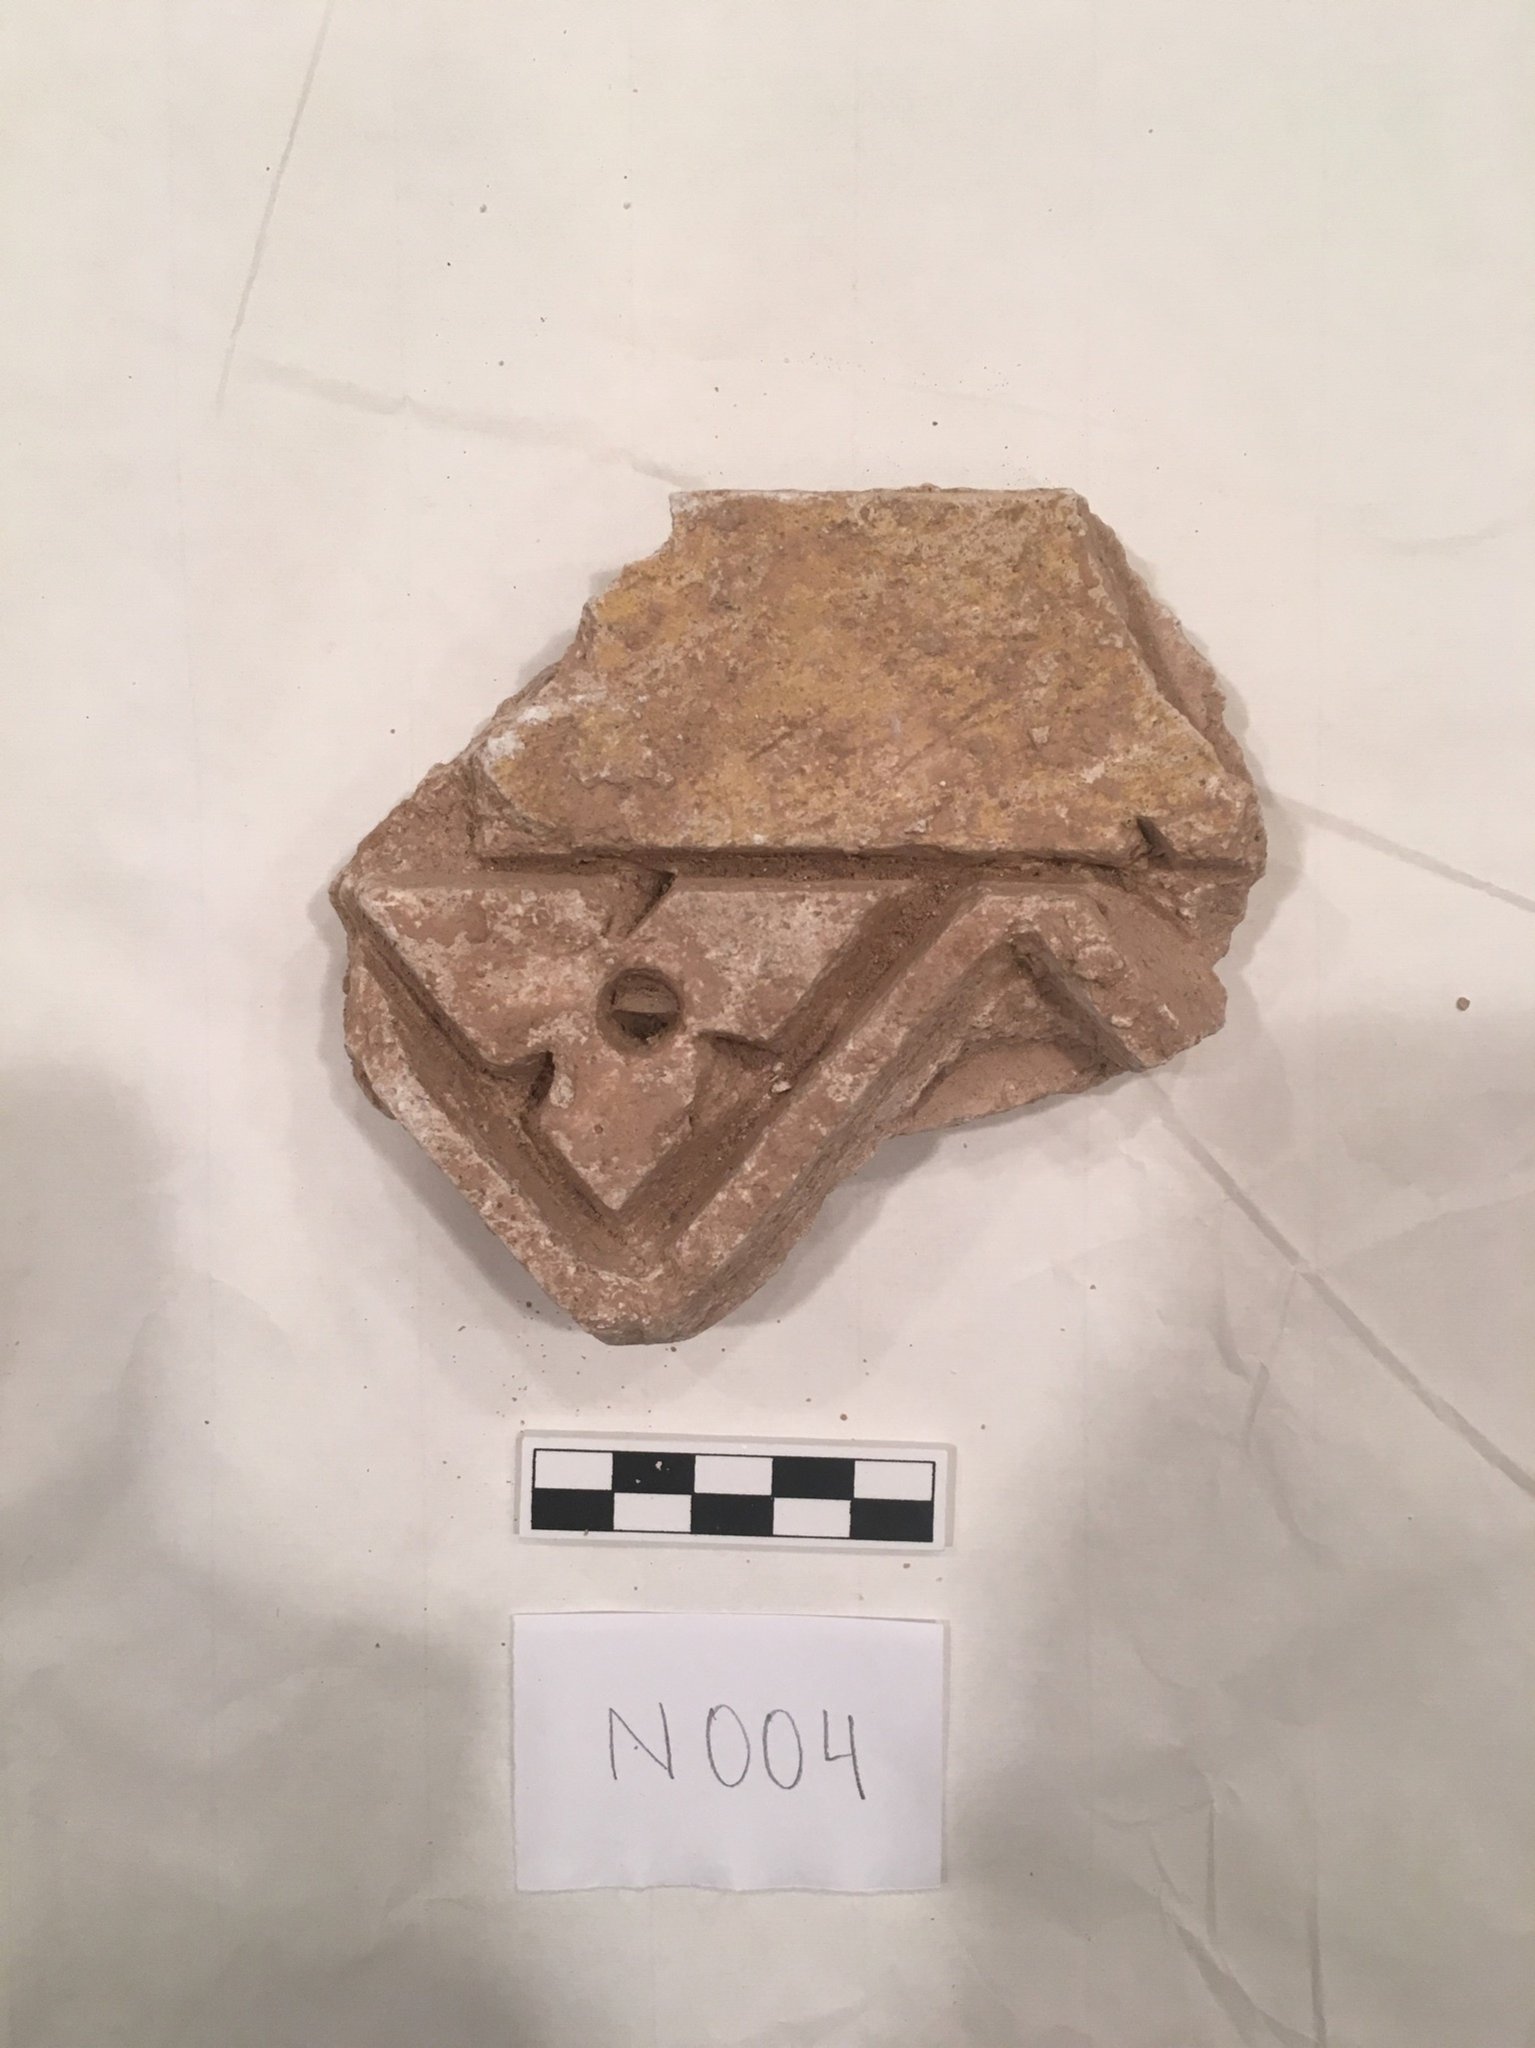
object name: fragment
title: Stucco Fragment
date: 701-1200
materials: plaster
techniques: carving, painting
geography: iran